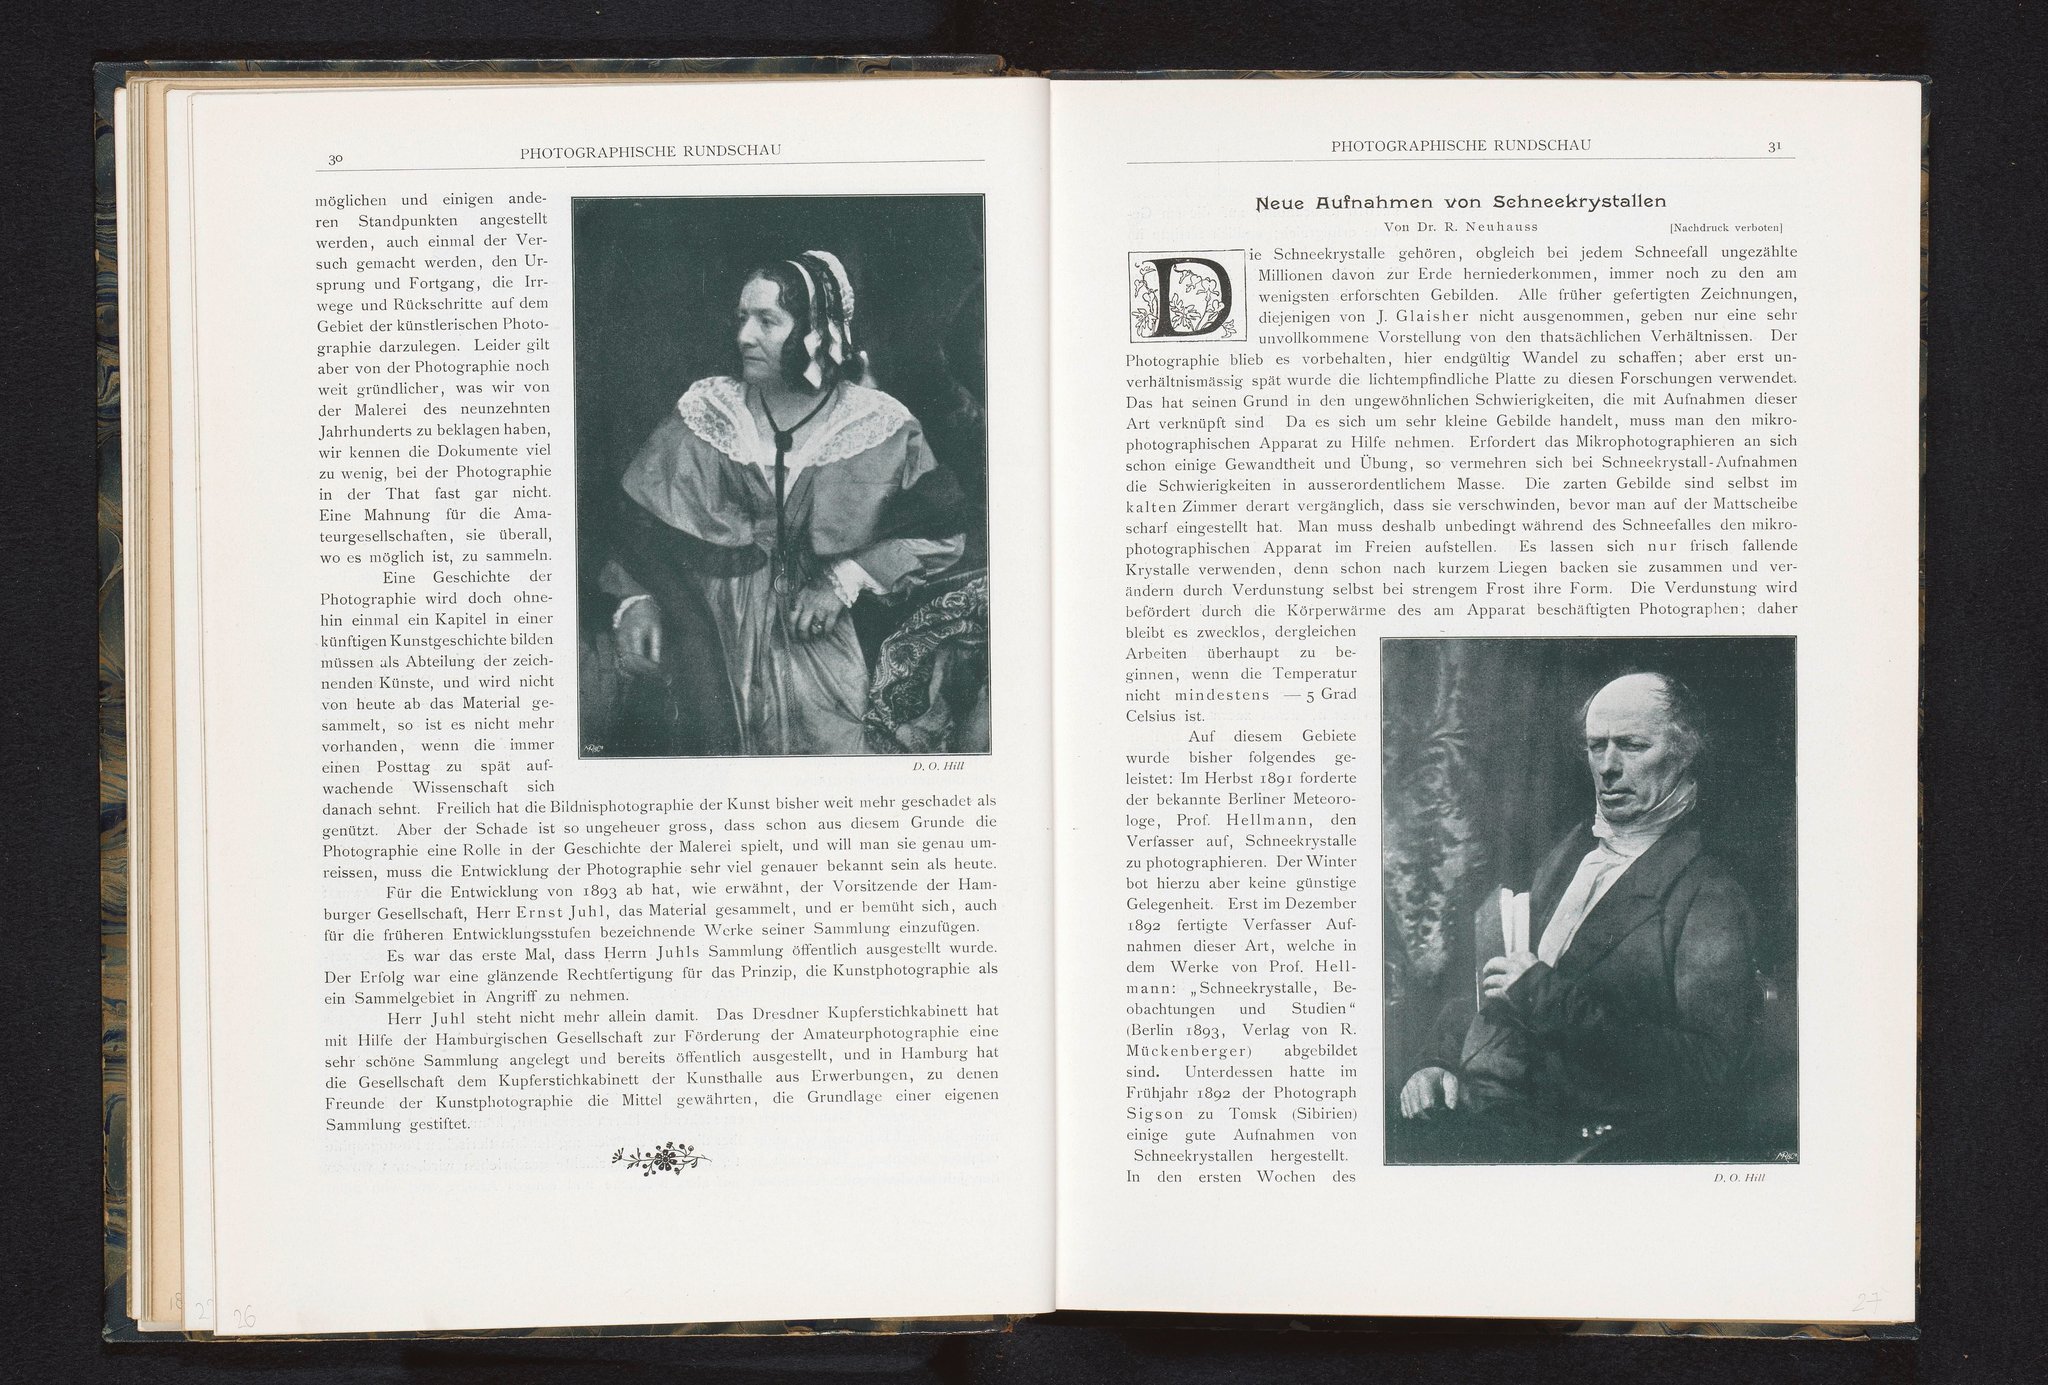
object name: page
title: Portret van een onbekende man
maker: david octavius hill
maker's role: fotograaf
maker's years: 1802-1870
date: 1895-1900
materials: paper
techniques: autotype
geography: berlin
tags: adult man, historical persons